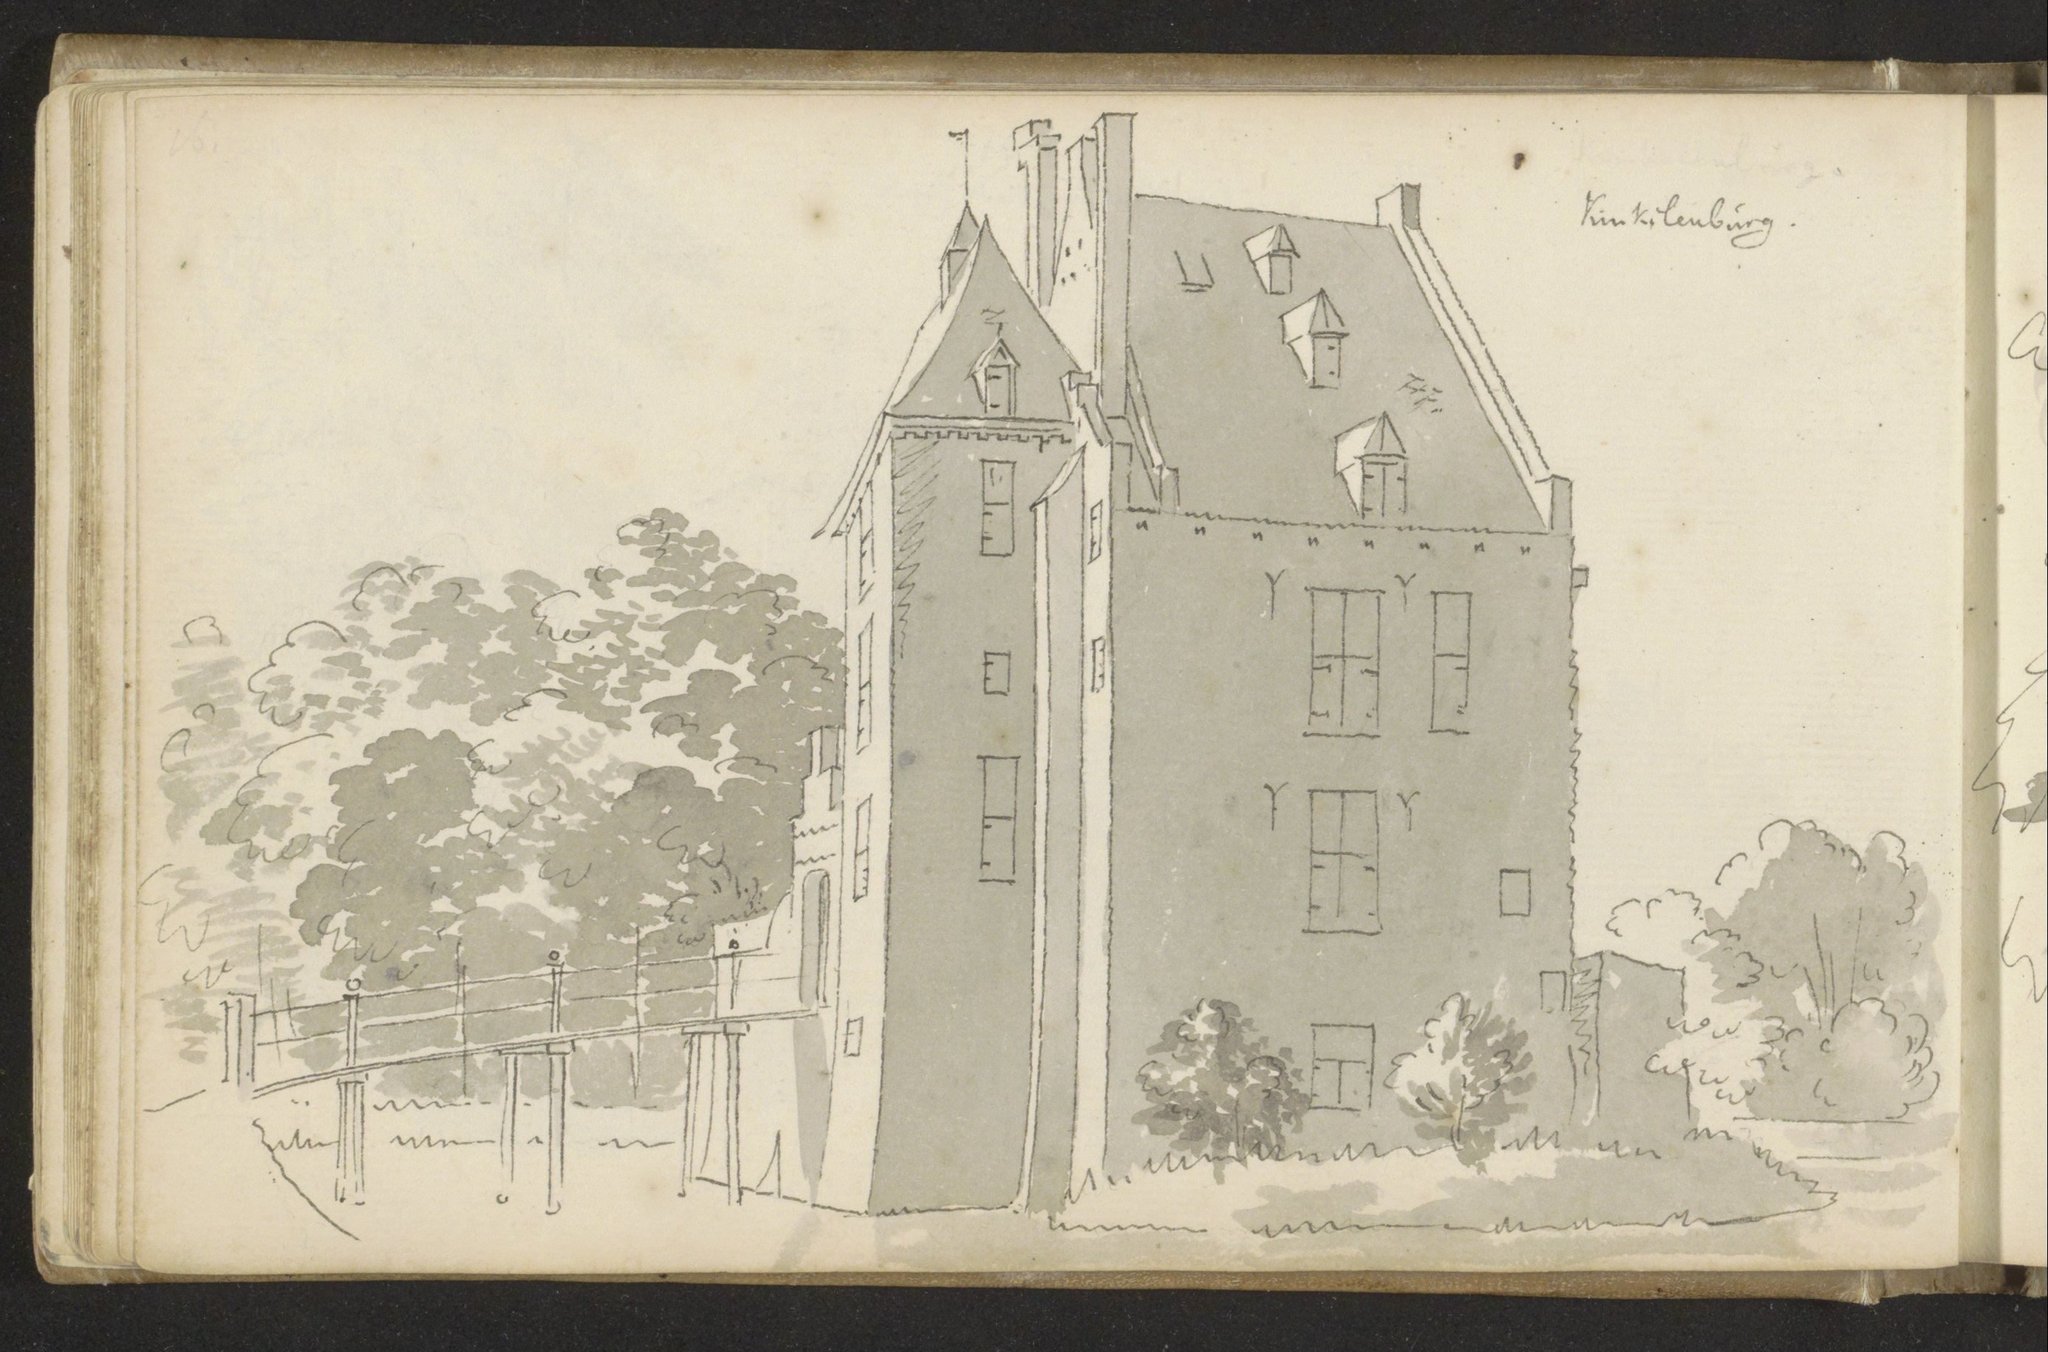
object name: sketchbook leaf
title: Kasteel Kinkelenburg te Bemmel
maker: abraham de haen (ii)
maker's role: draughtsman, print maker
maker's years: 1707-1748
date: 1731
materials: ink, paper, pencil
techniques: brush, pen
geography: bemmel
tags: castle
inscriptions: annotation: ‘Kinkelenburg.’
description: Blad 15 verso uit een schetsboek met 69 bladen.